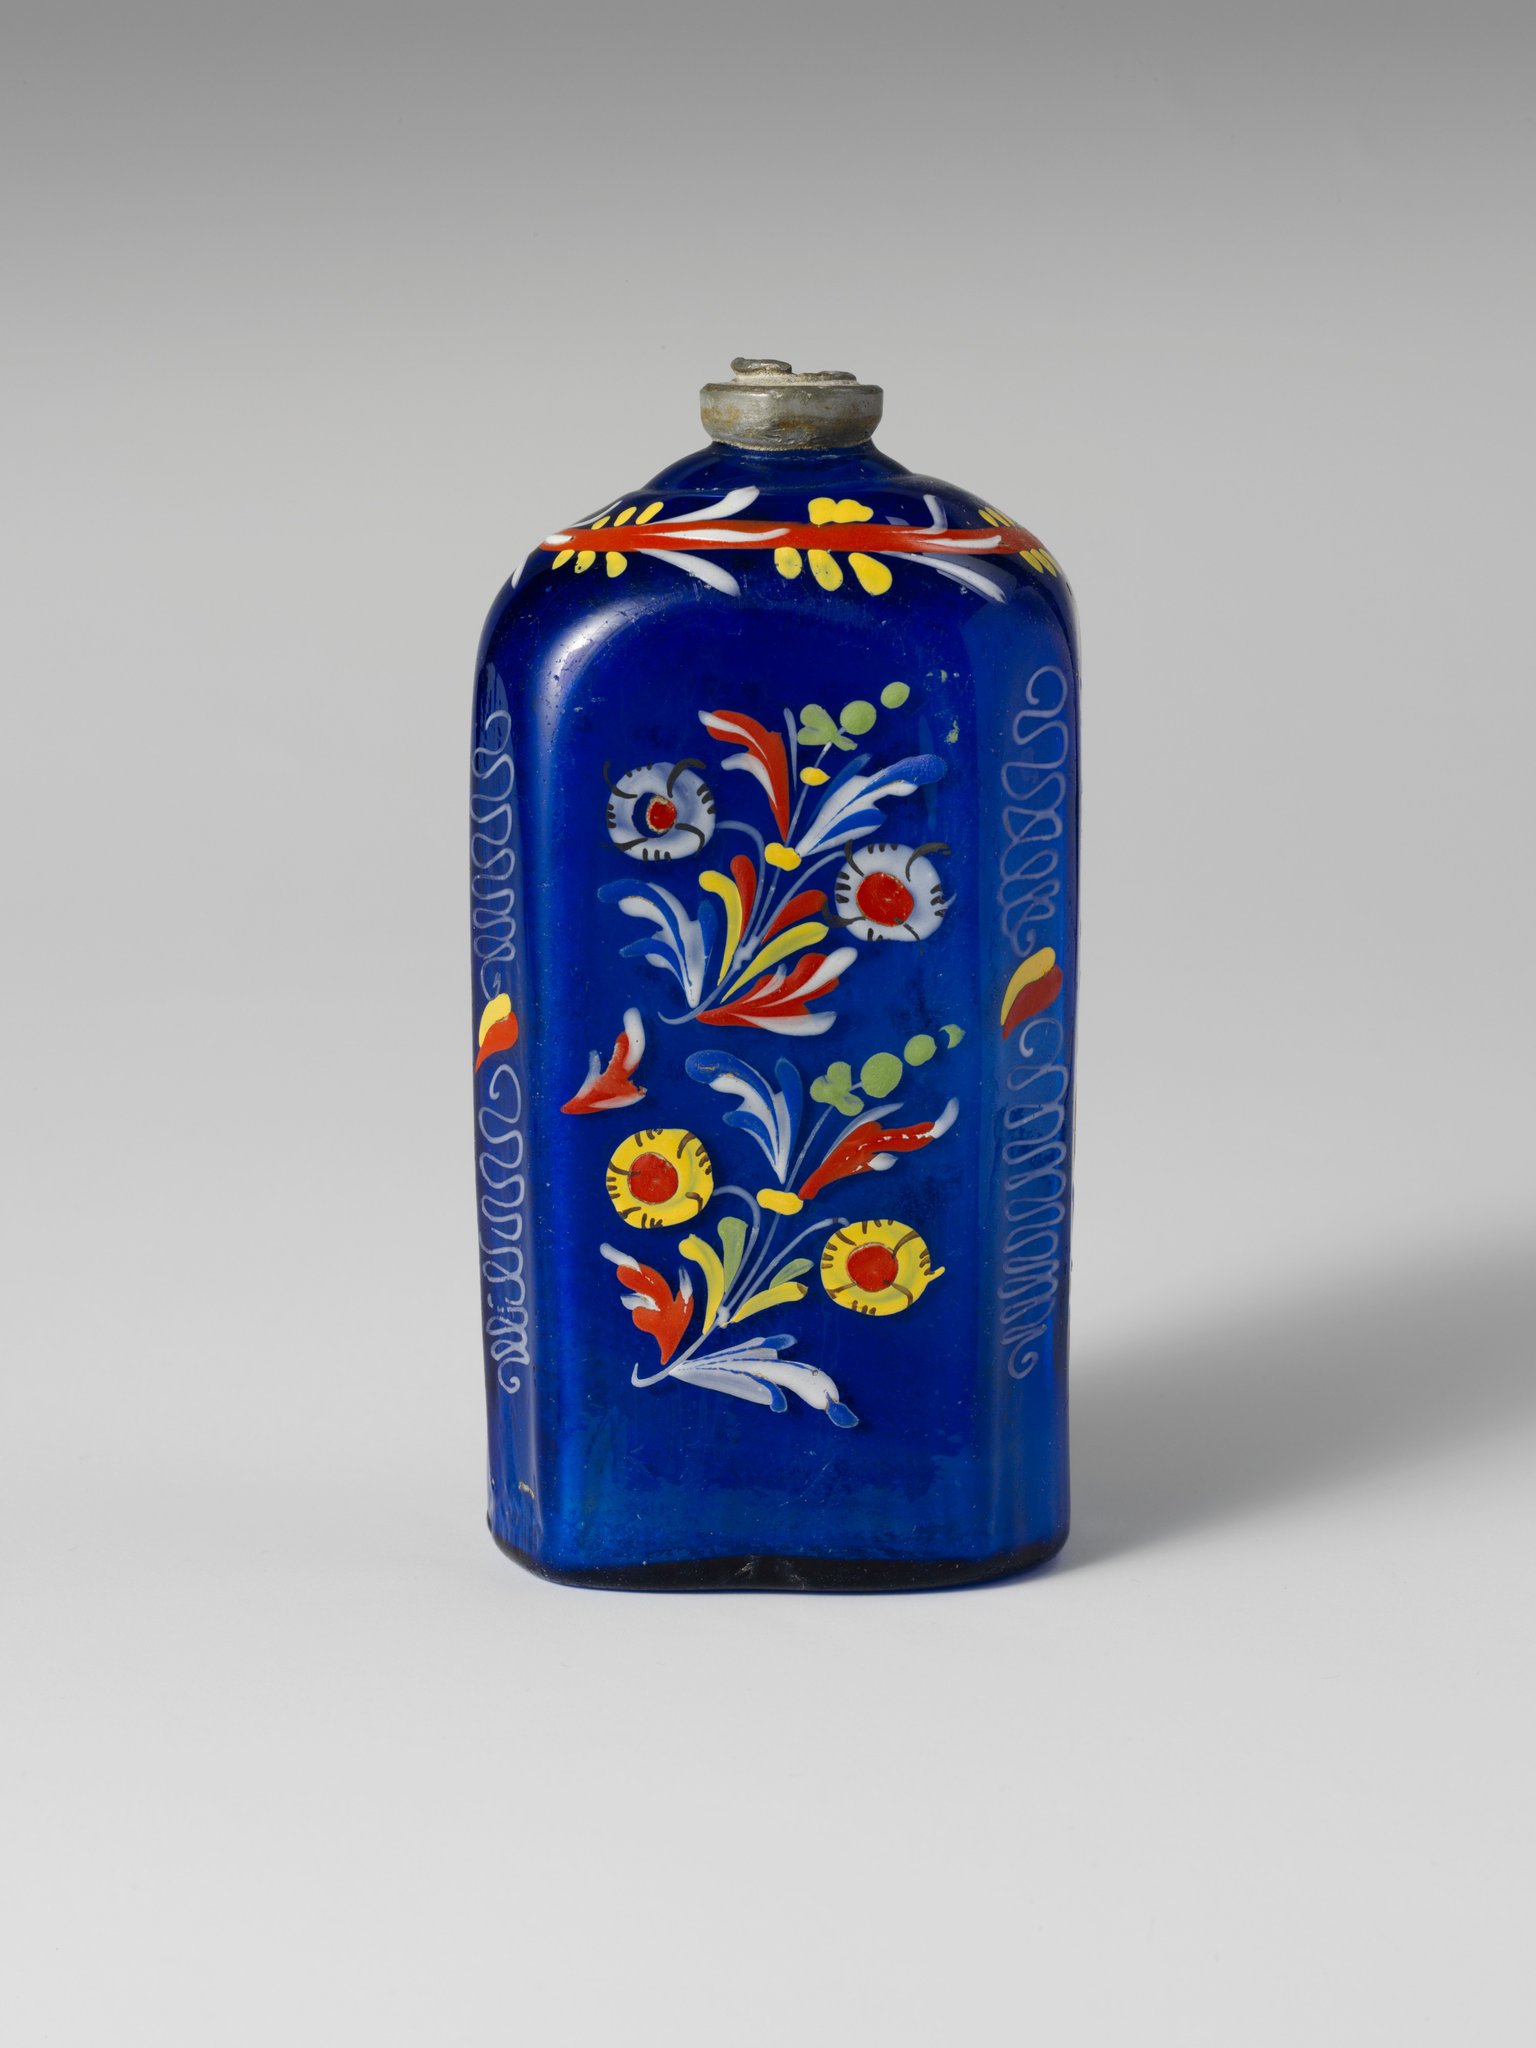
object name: bottle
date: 1700-1800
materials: enamel, glass, lead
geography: czech republic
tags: flowers